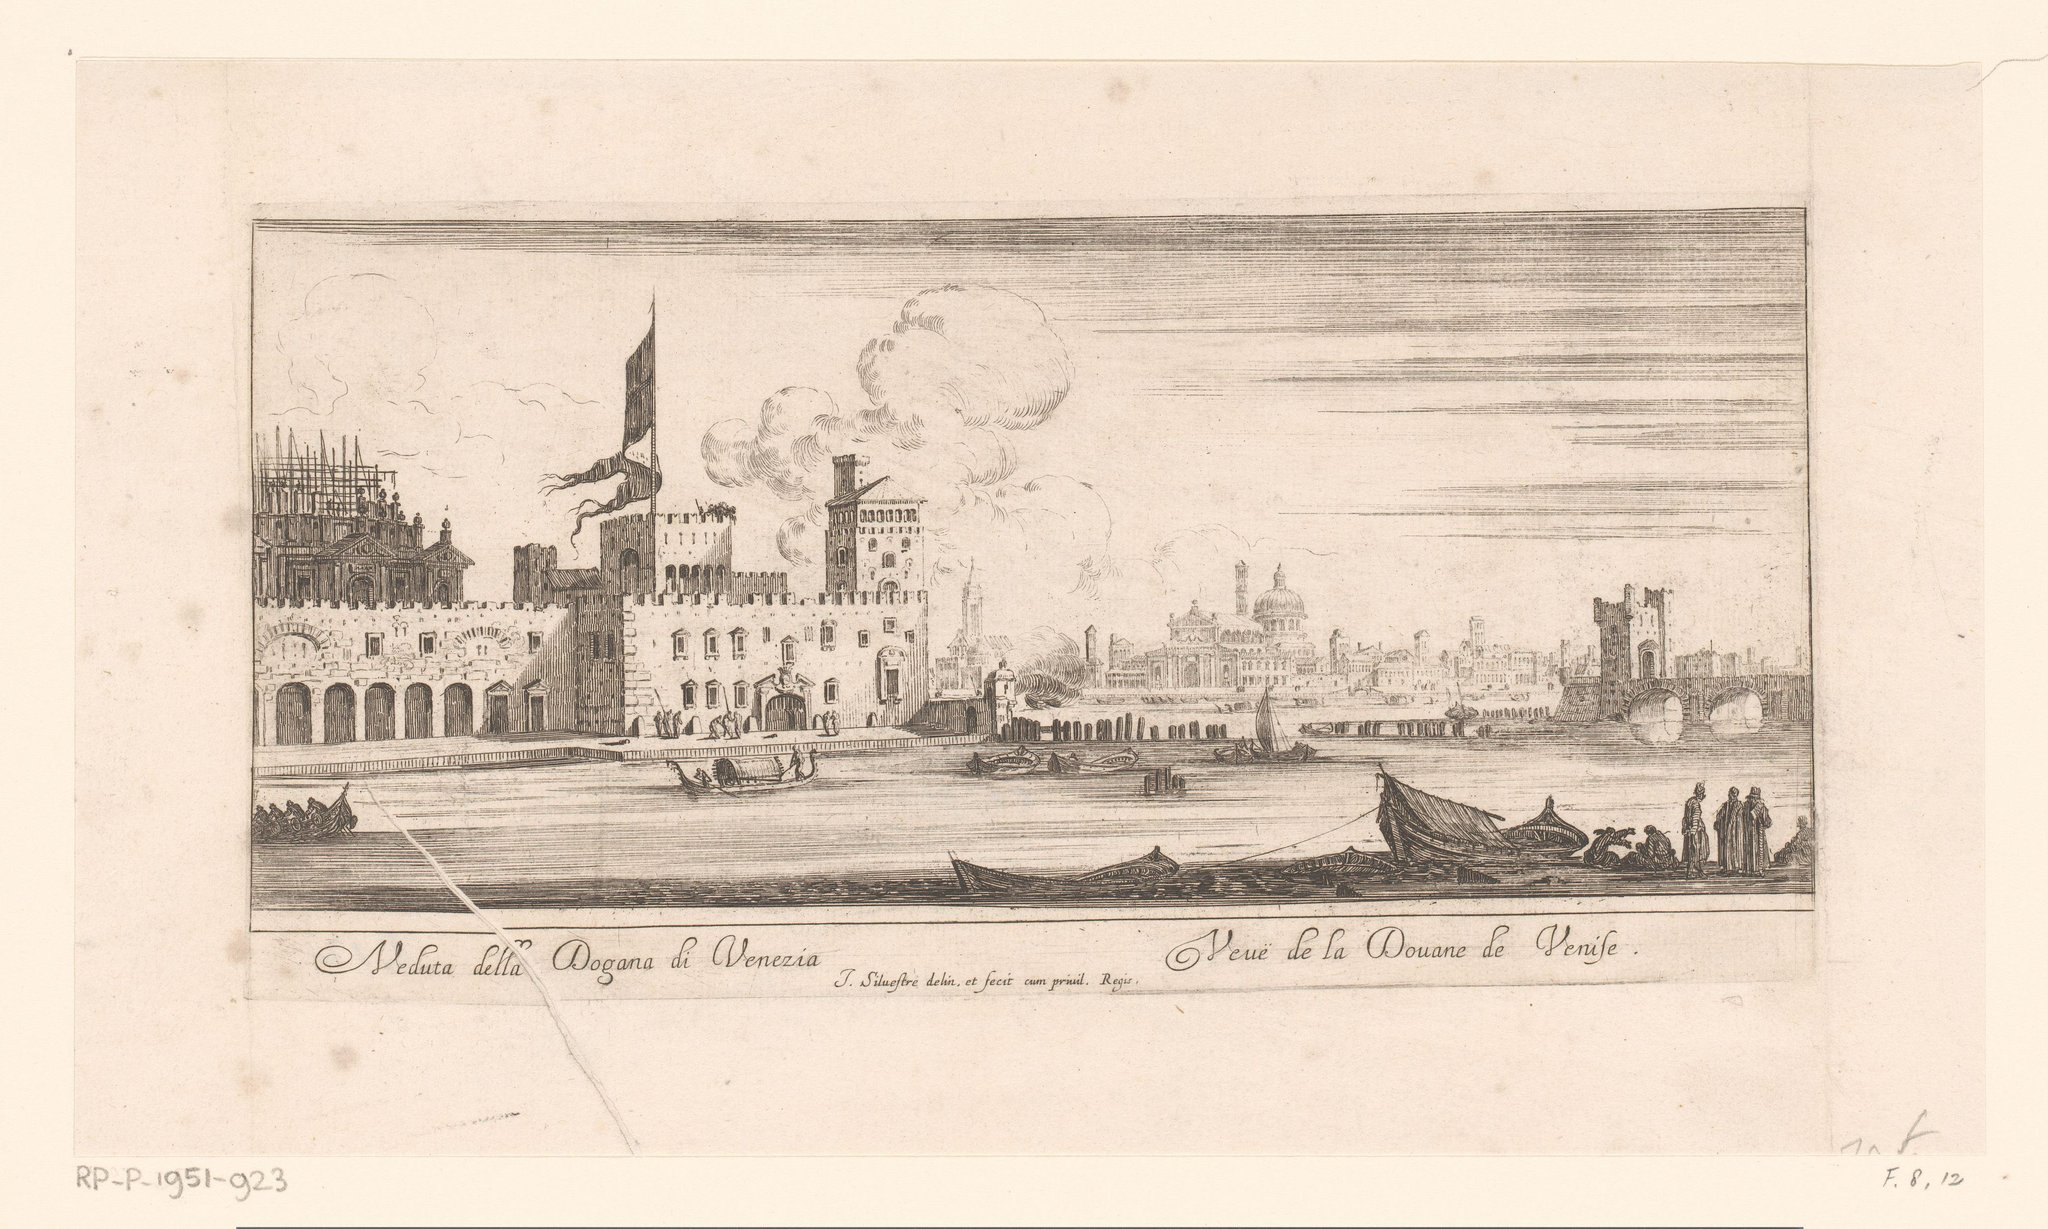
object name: print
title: Veduta della Dogana di Venezia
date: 1631-1691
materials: paper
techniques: etching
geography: france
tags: harbour, city-view in general; 'veduta'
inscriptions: collector's mark: Lugt 2228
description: Prent maakt deel uit van een ongenummerde serie van twaalf prenten.